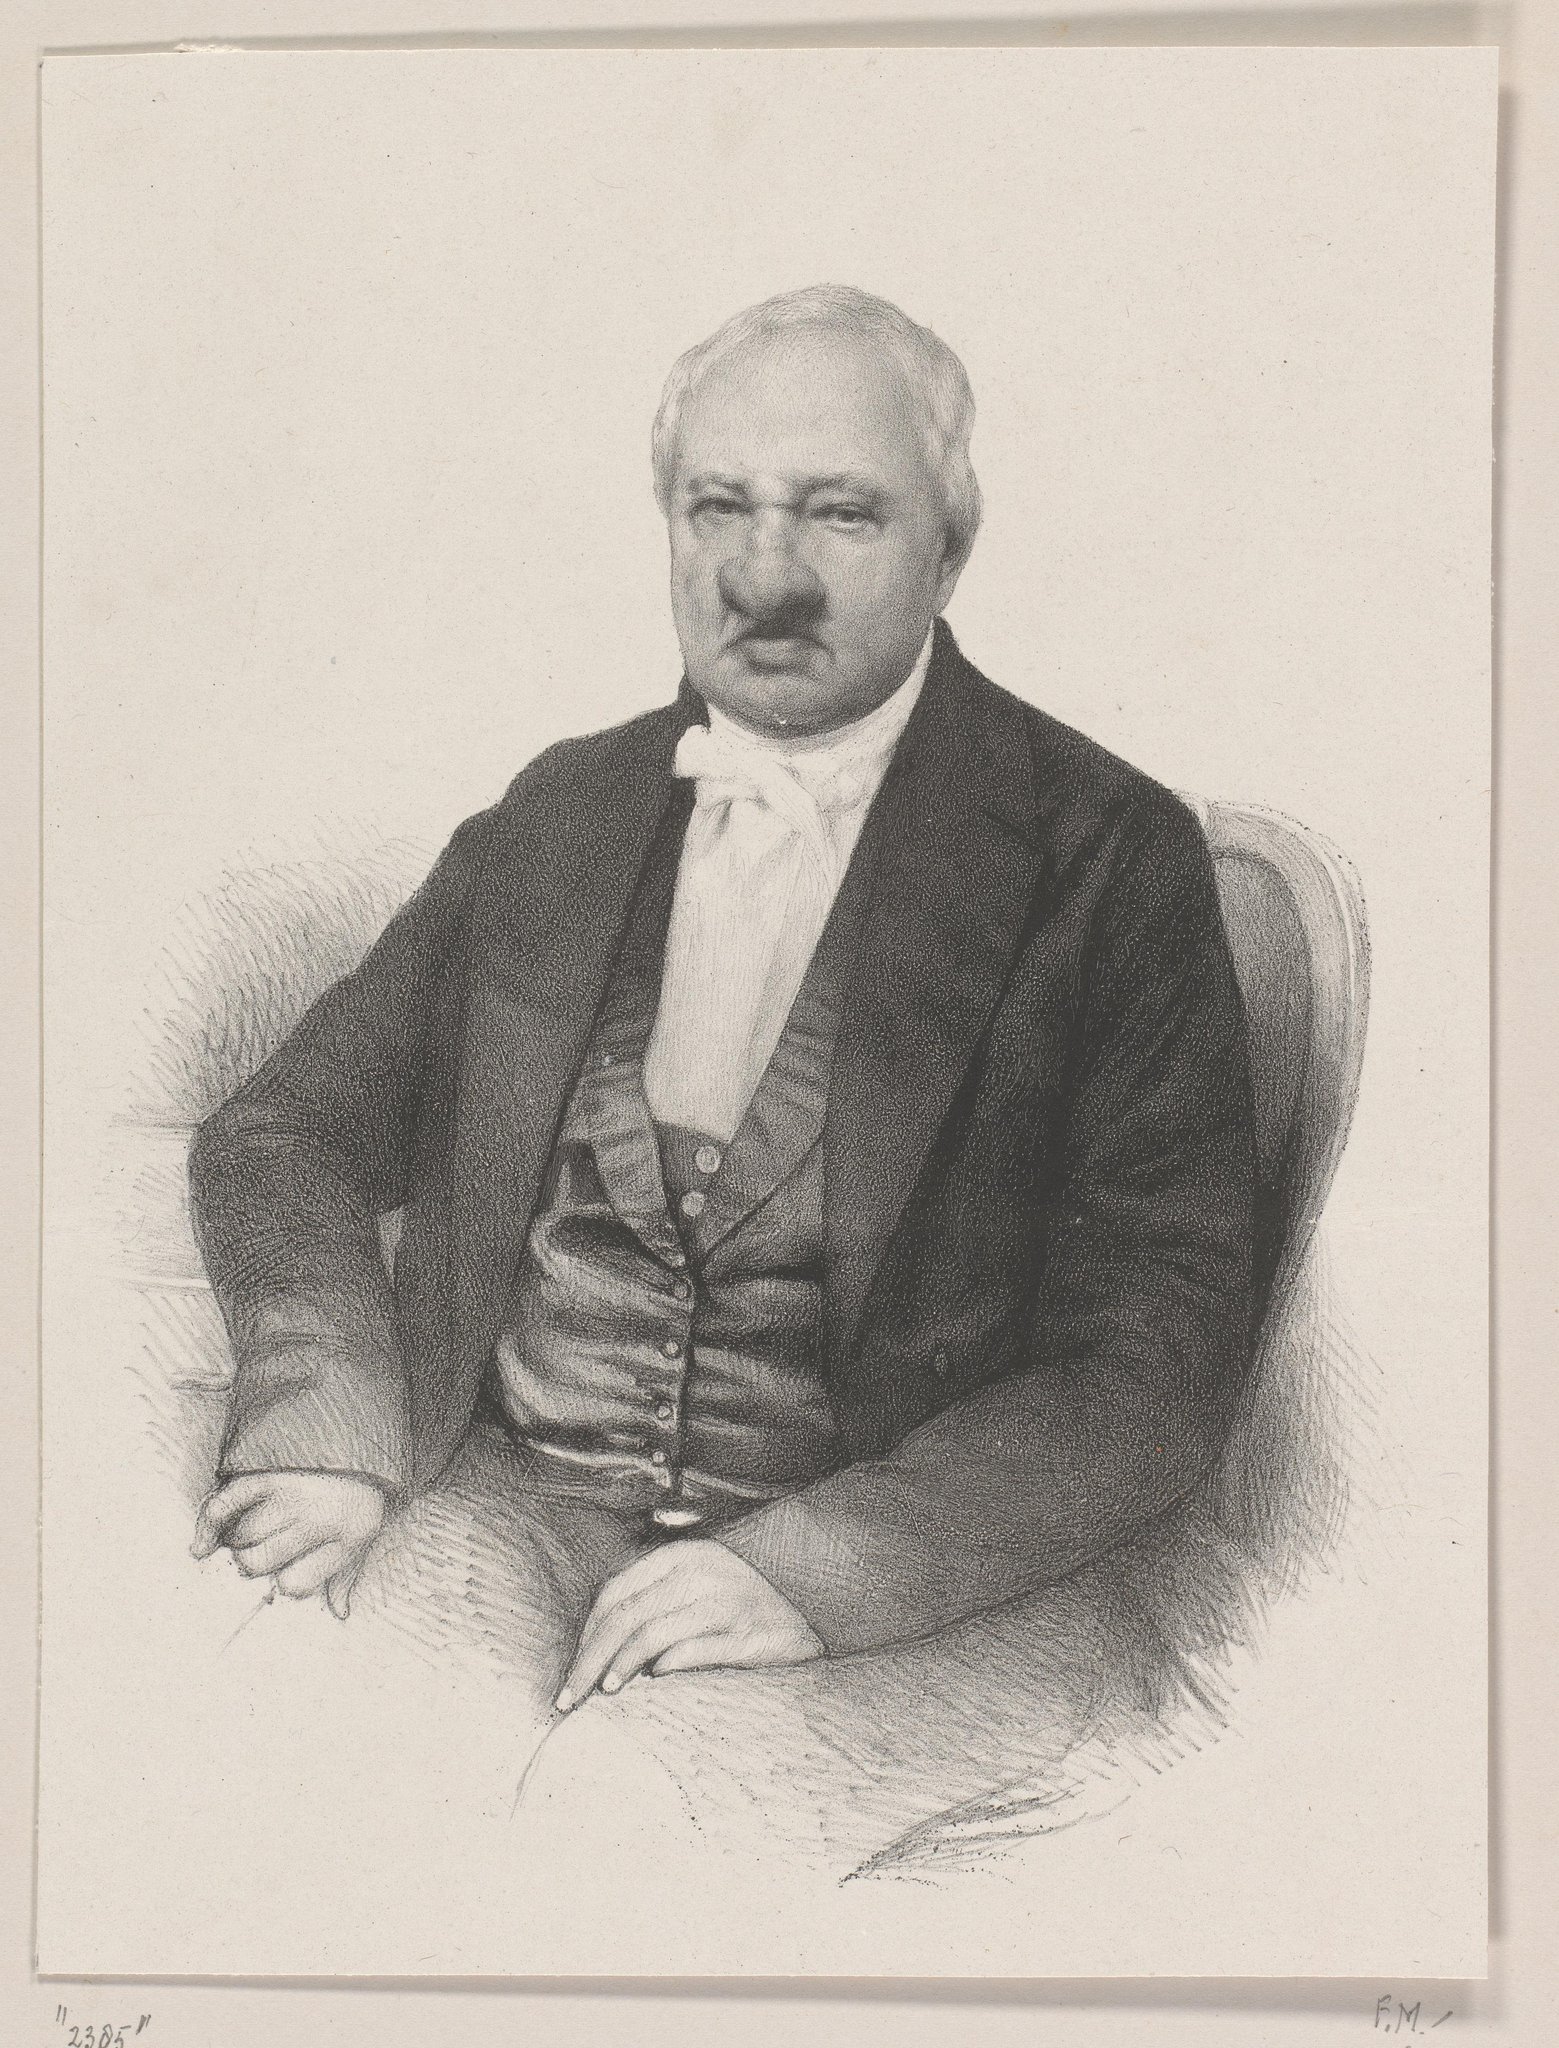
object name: print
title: Portret van Hermanus Willem Witteveen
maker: Anonymous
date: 1855-1884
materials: paper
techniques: lithograph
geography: netherlands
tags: historical persons